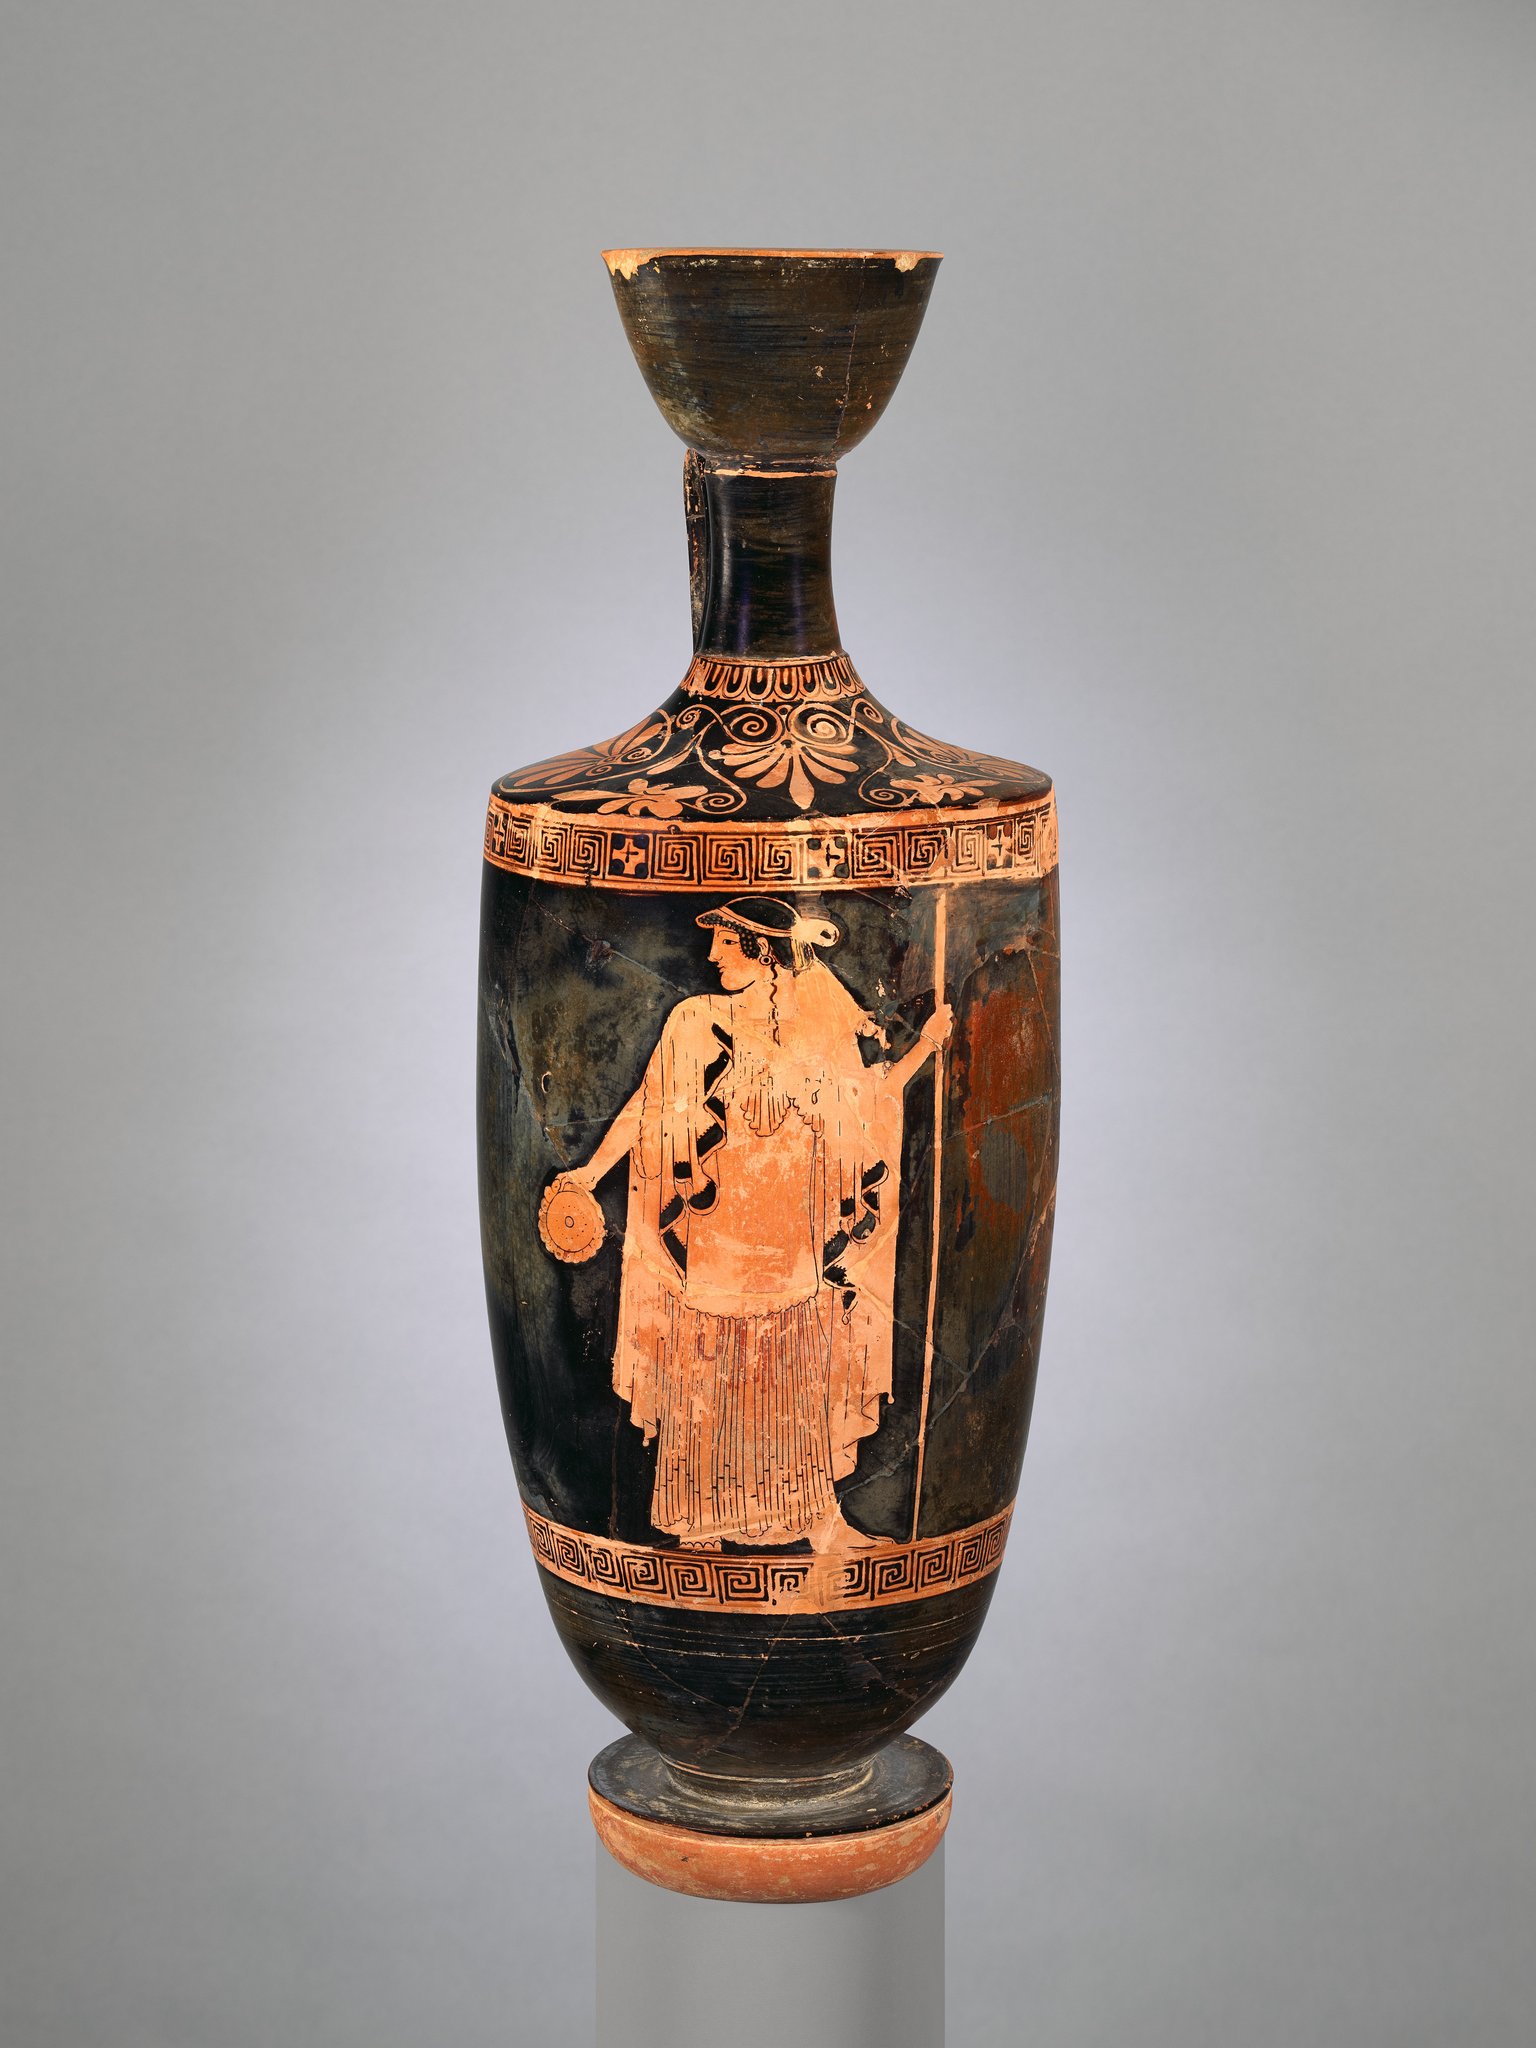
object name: lekythos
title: Terracotta lekythos (oil flask)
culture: greek, attic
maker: brygos painter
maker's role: artist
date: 490-480 BCE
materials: terracotta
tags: goddess